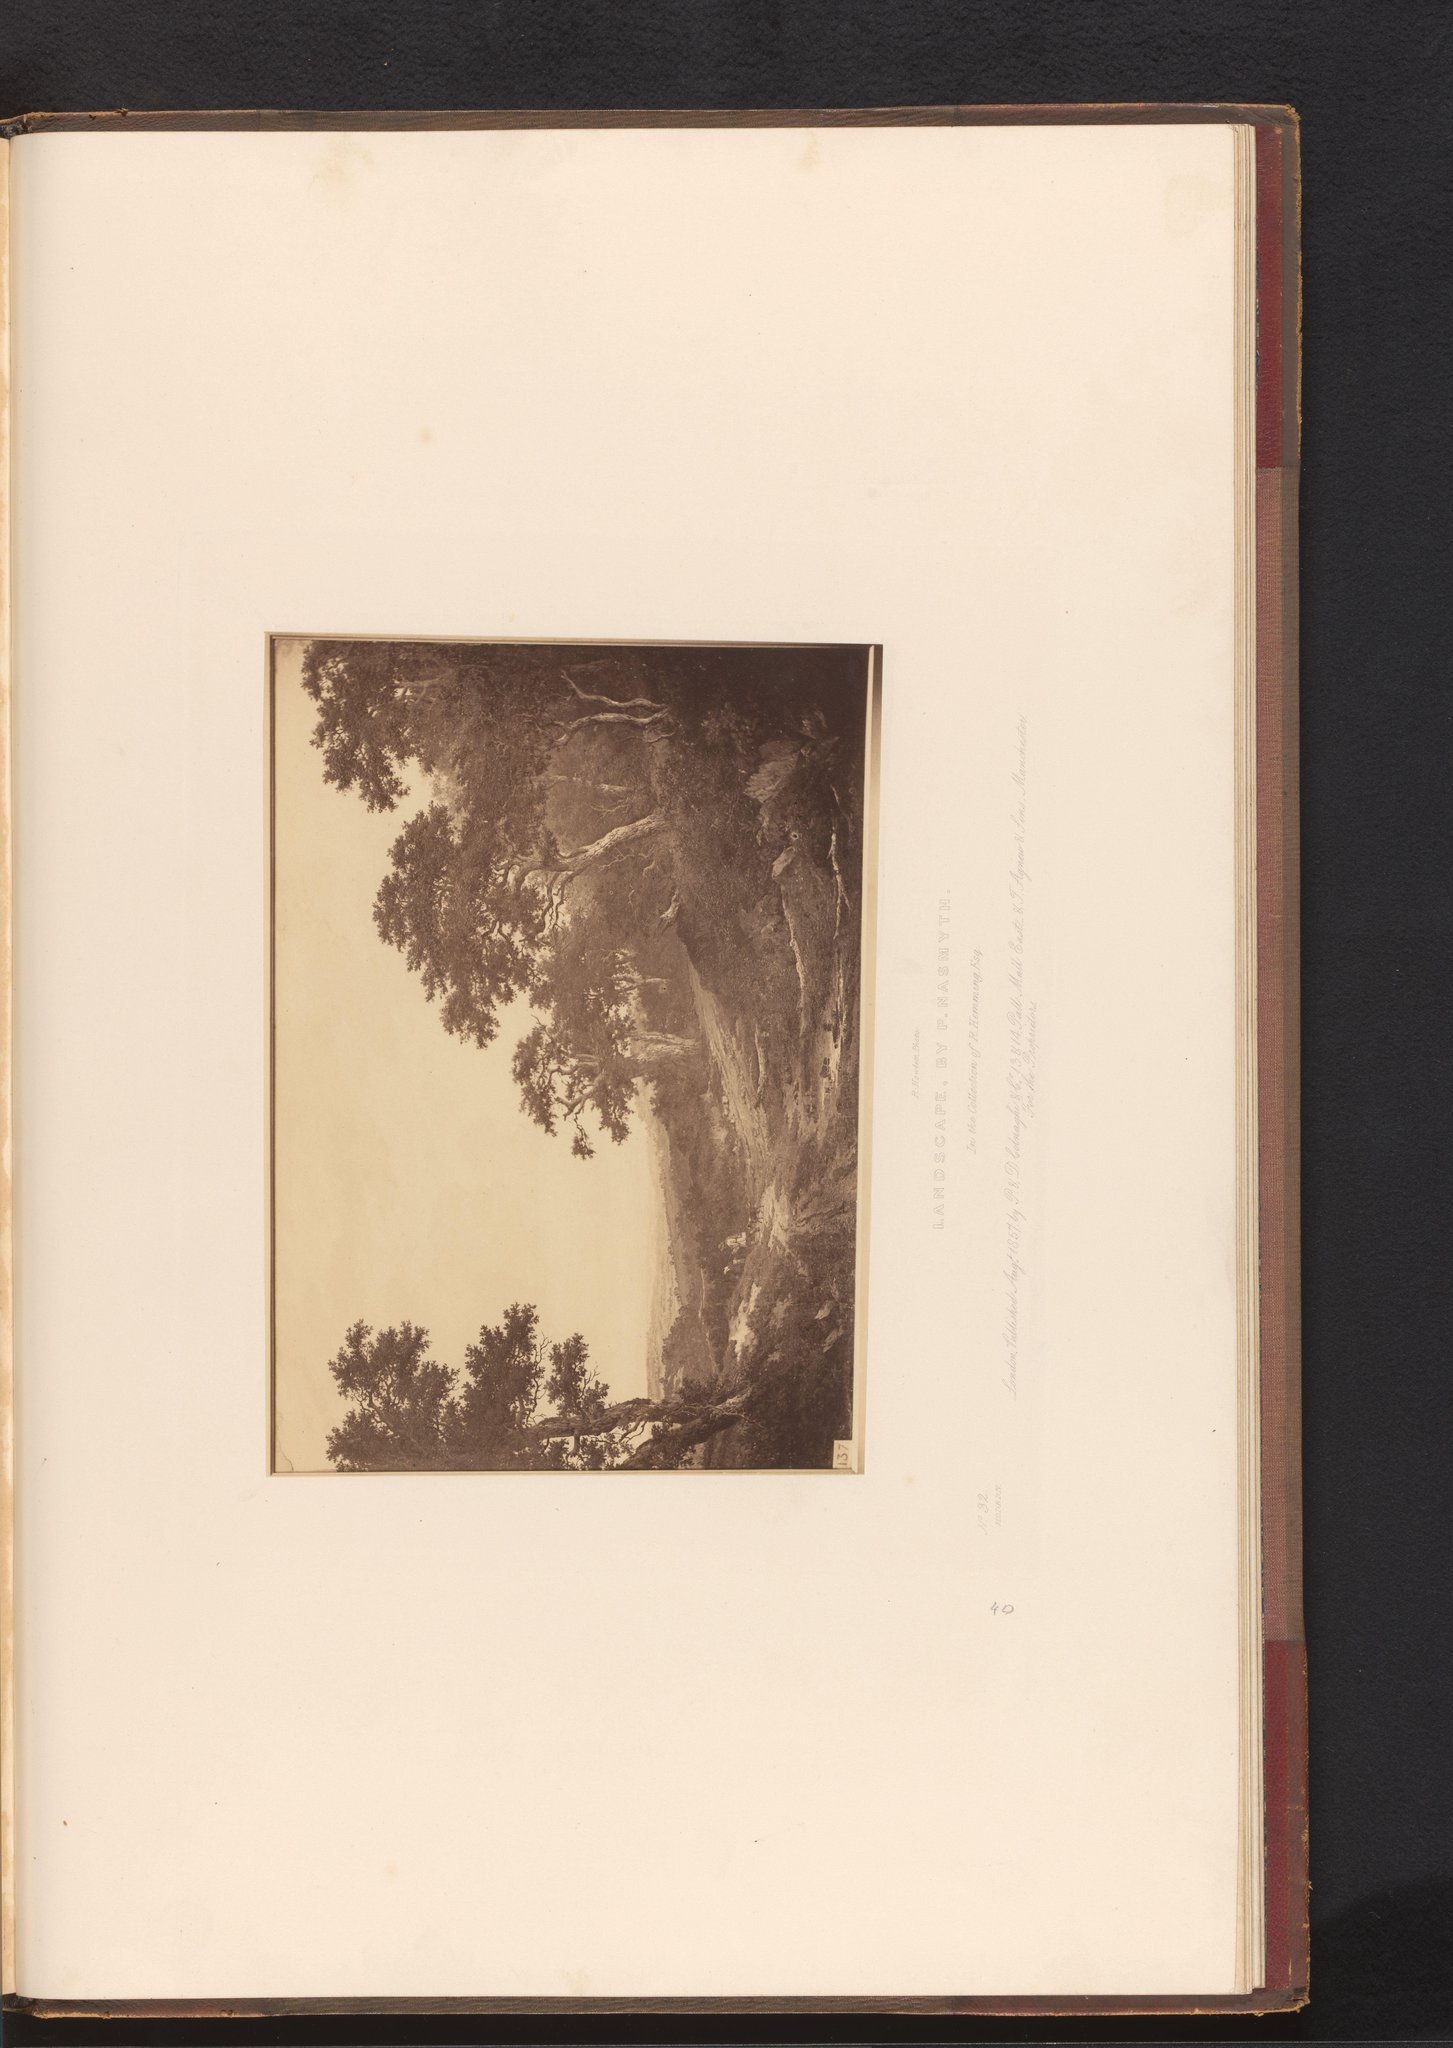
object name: photograph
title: Landscape, by P. Nasmyth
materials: photographic support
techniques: albumen print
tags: landscapes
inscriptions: number: ‘40’, inscription: ‘In the Collection of R. Hemming, Esq./ London, Published Augt, 1857, by P. & D. Colnaghi & Co, 13 & 14, Pall Mall East & T. Agneur & Sons, Manchester./ For the Proprietors.’, number: ‘No. 32./ MODERN.’